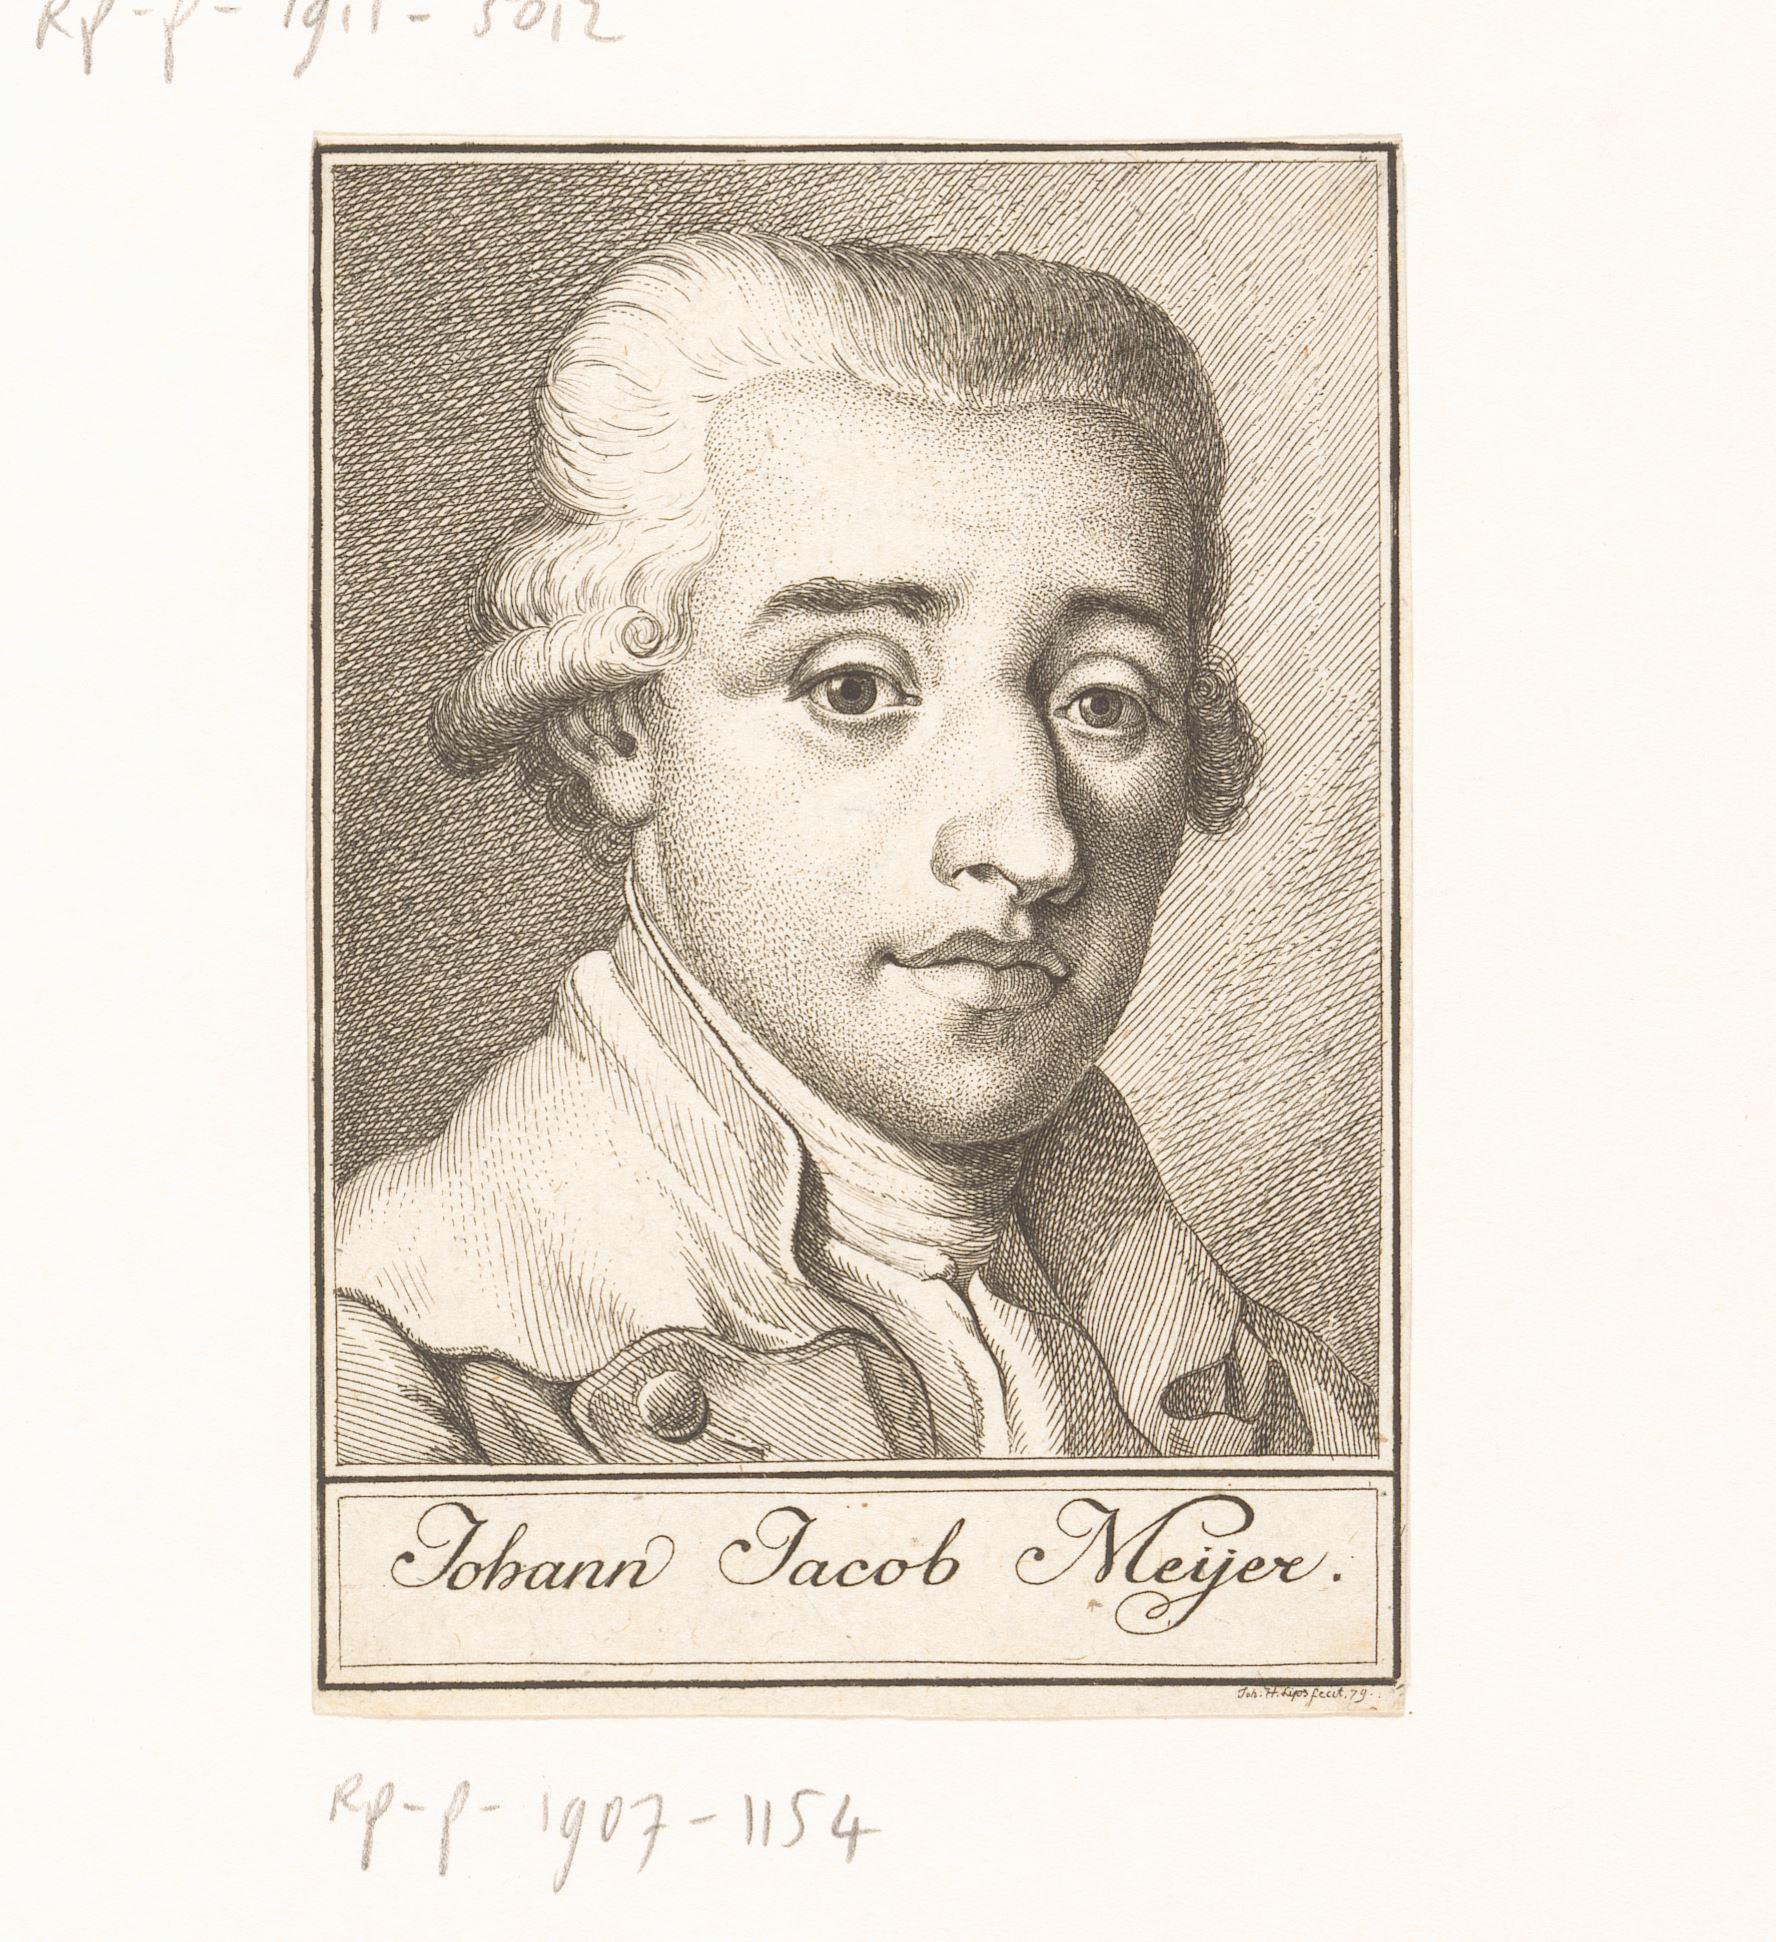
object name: print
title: Portret van Johann Jakob Meyer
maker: johann heinrich lips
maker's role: draughtsman, painter, print maker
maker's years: 1758-1817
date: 1779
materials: paper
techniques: engraving, etching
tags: painter, print maker, artist, historical persons, portrait, self-portrait of artist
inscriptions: collector's mark: Lugt 2228